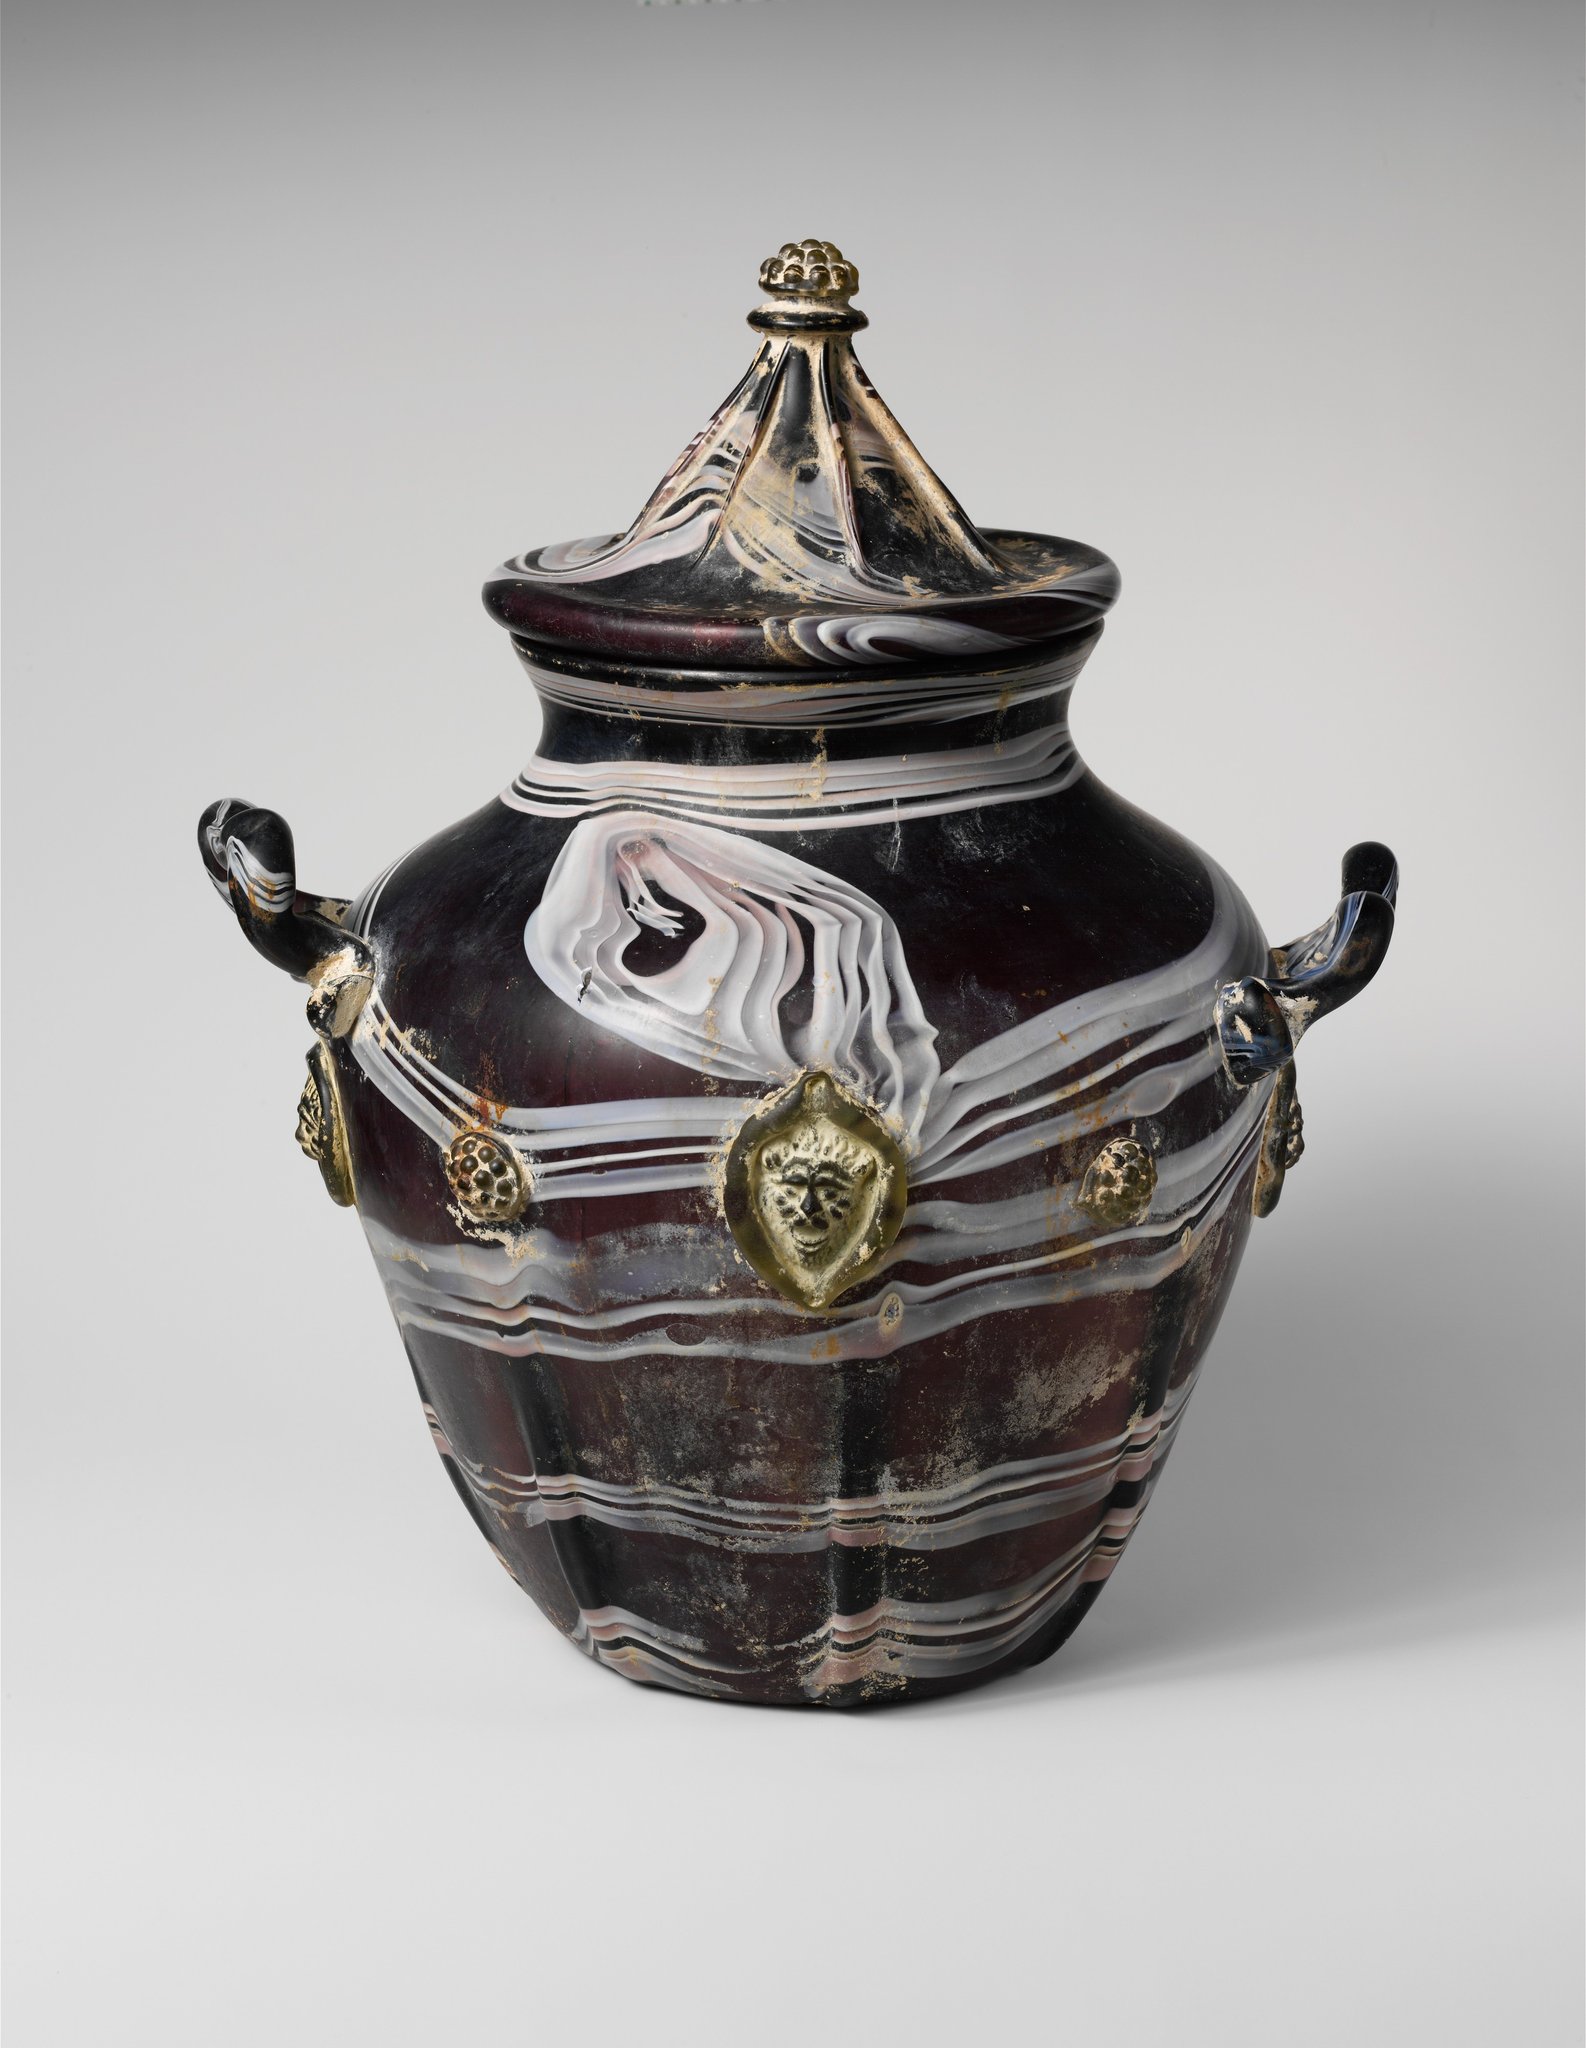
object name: urn with cover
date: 1801-1900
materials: glass